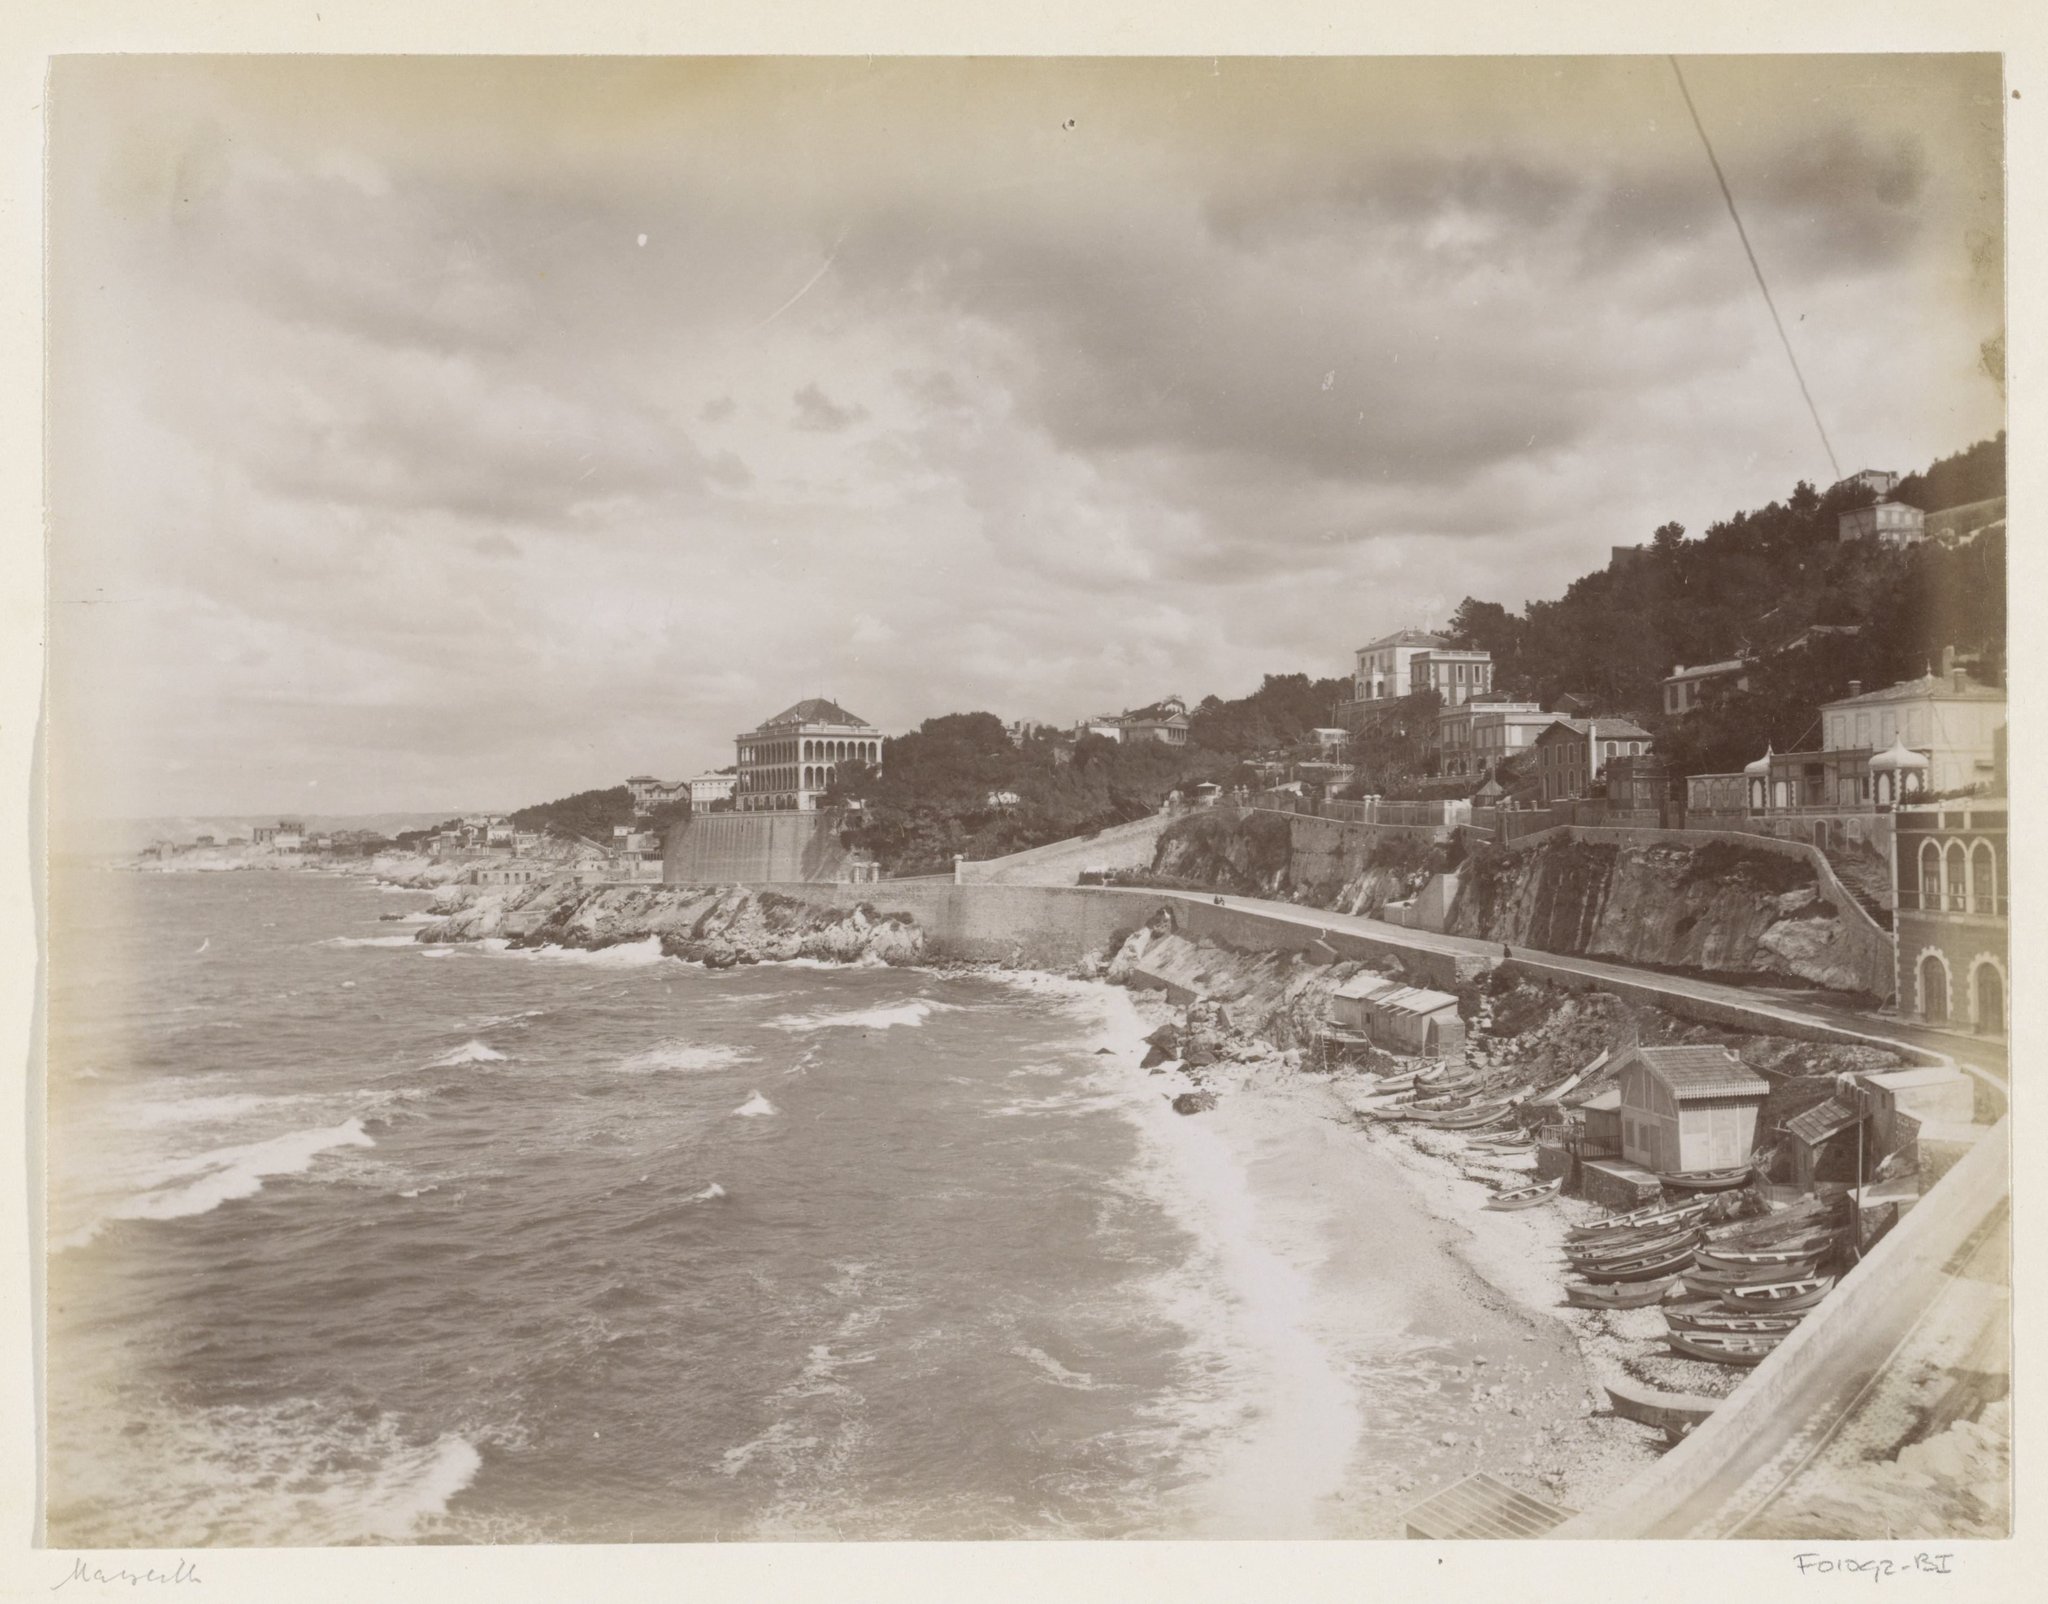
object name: photograph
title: Gezicht op de kust bij Marseille met boten, bebouwing en een weg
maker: Anonymous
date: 1880-1900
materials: cardboard, paper, photographic support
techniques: albumen print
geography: marseille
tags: coast, marseille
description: Onderdeel van Reisalbum met foto's van bezienswaardigheden in België en Frankrijk.